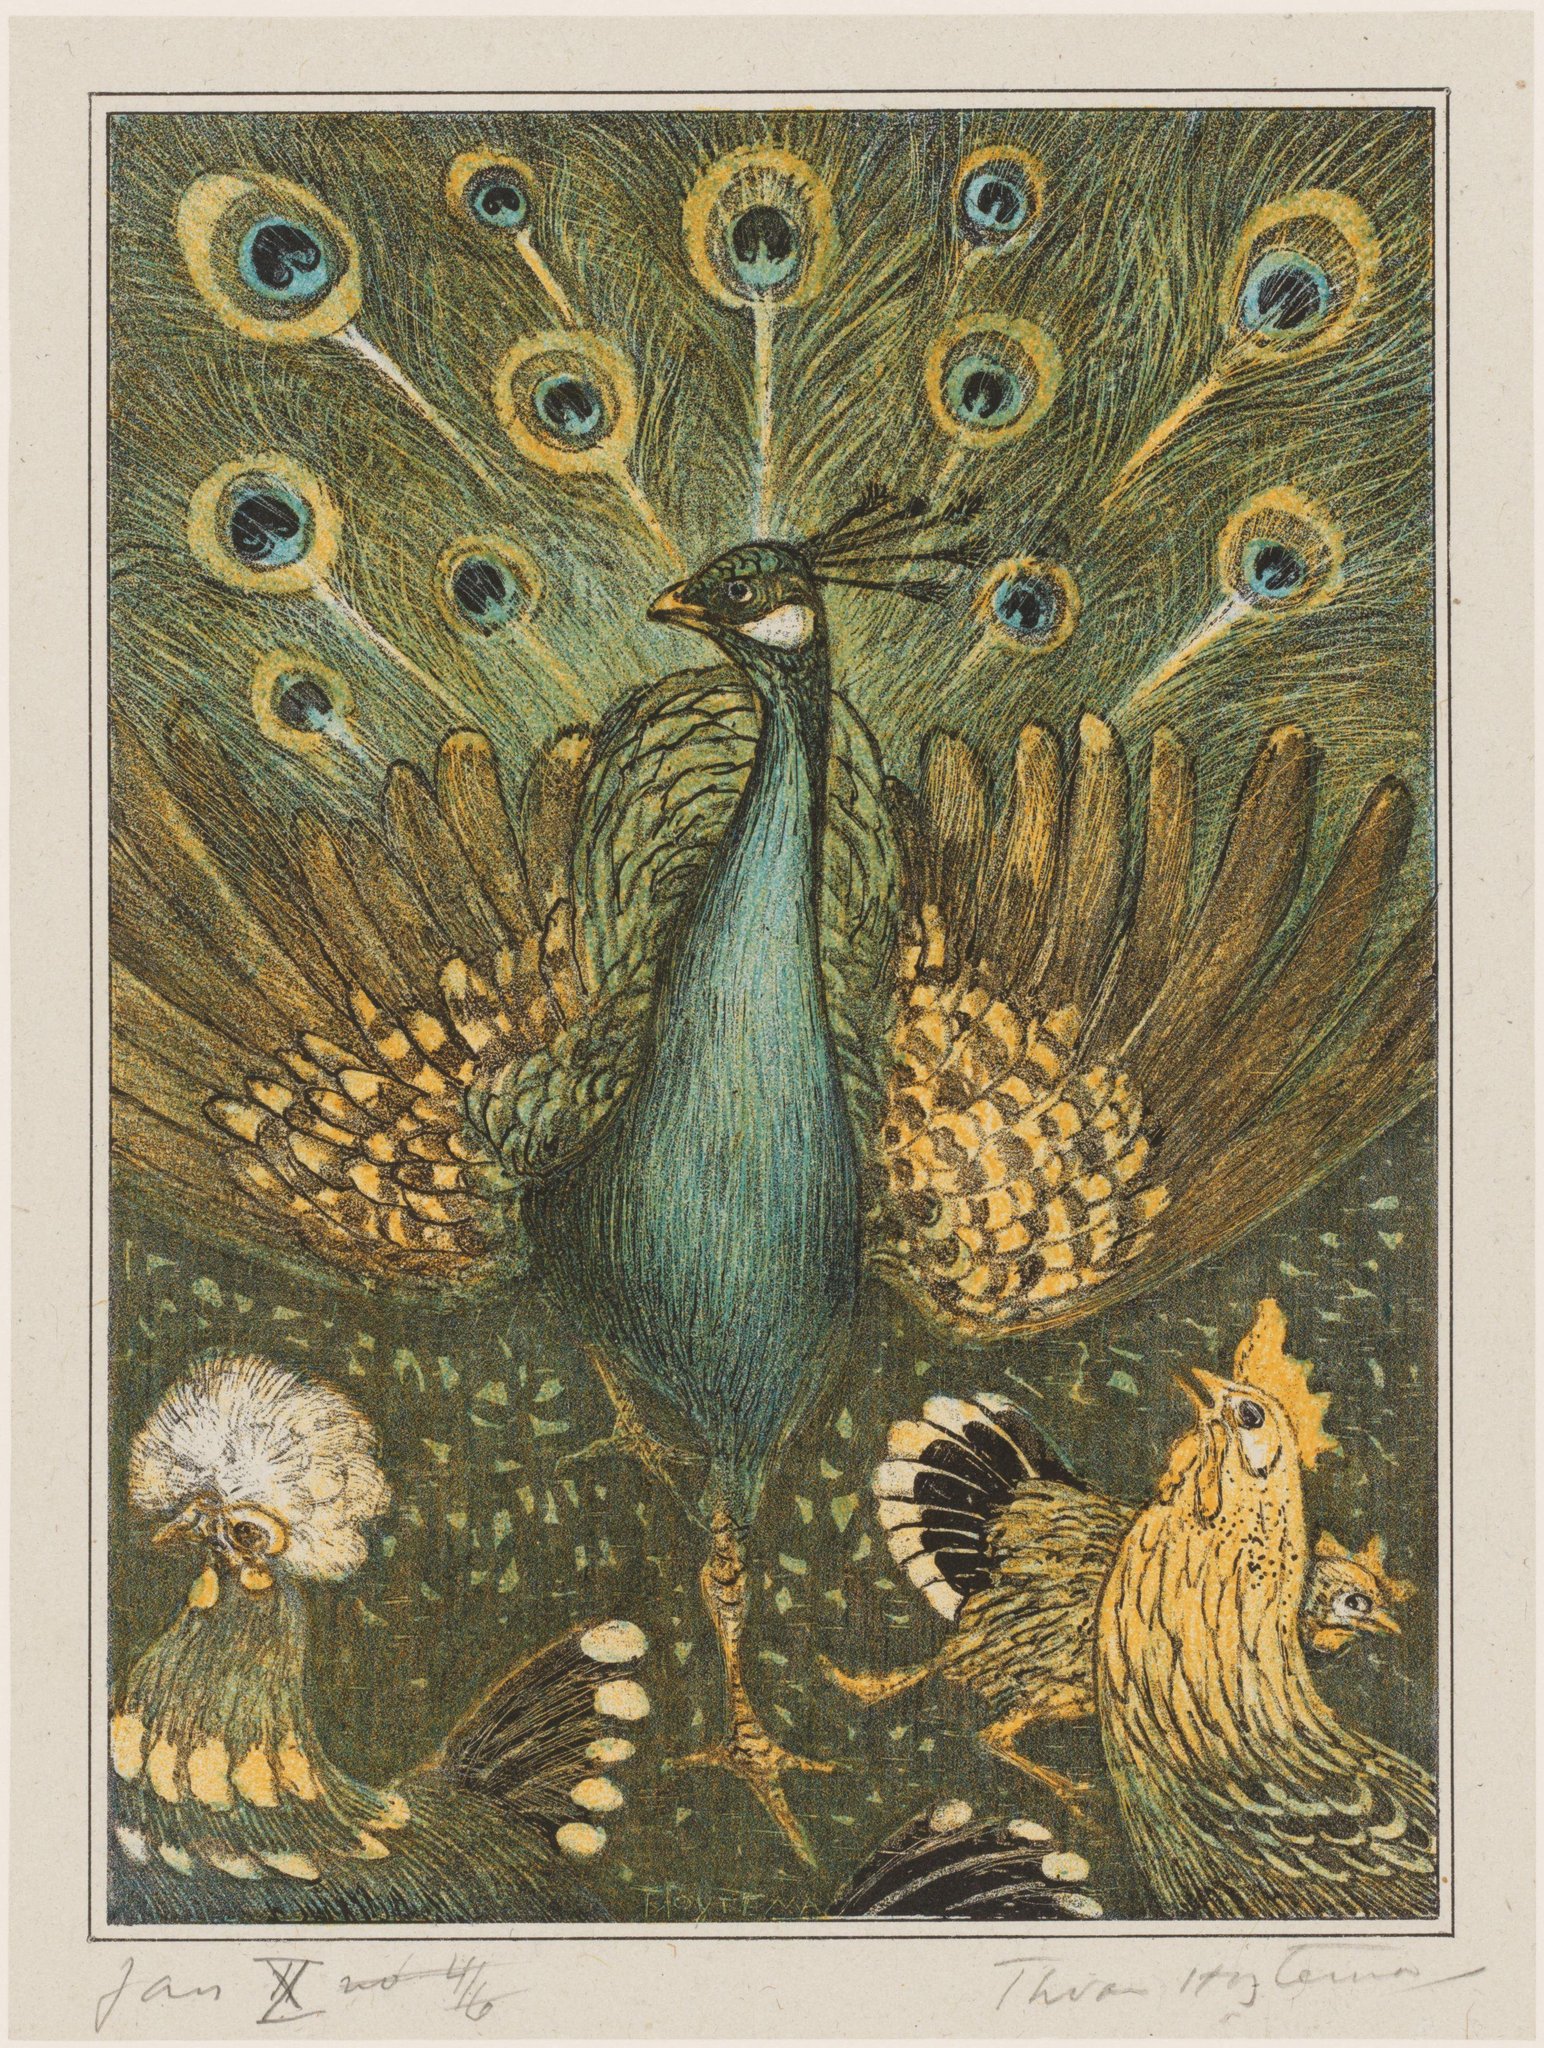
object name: print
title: Pauw met kippen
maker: theo van hoytema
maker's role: draughtsman, painter, print maker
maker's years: 1863-1917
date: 1878-1910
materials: paper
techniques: lithograph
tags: ornamental birds: peacock, fowl (cock, hen, chicken, etc.)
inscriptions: collector's mark: Lugt 2233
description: Prent is een proefdruk voor kalenderblad januari 1910.